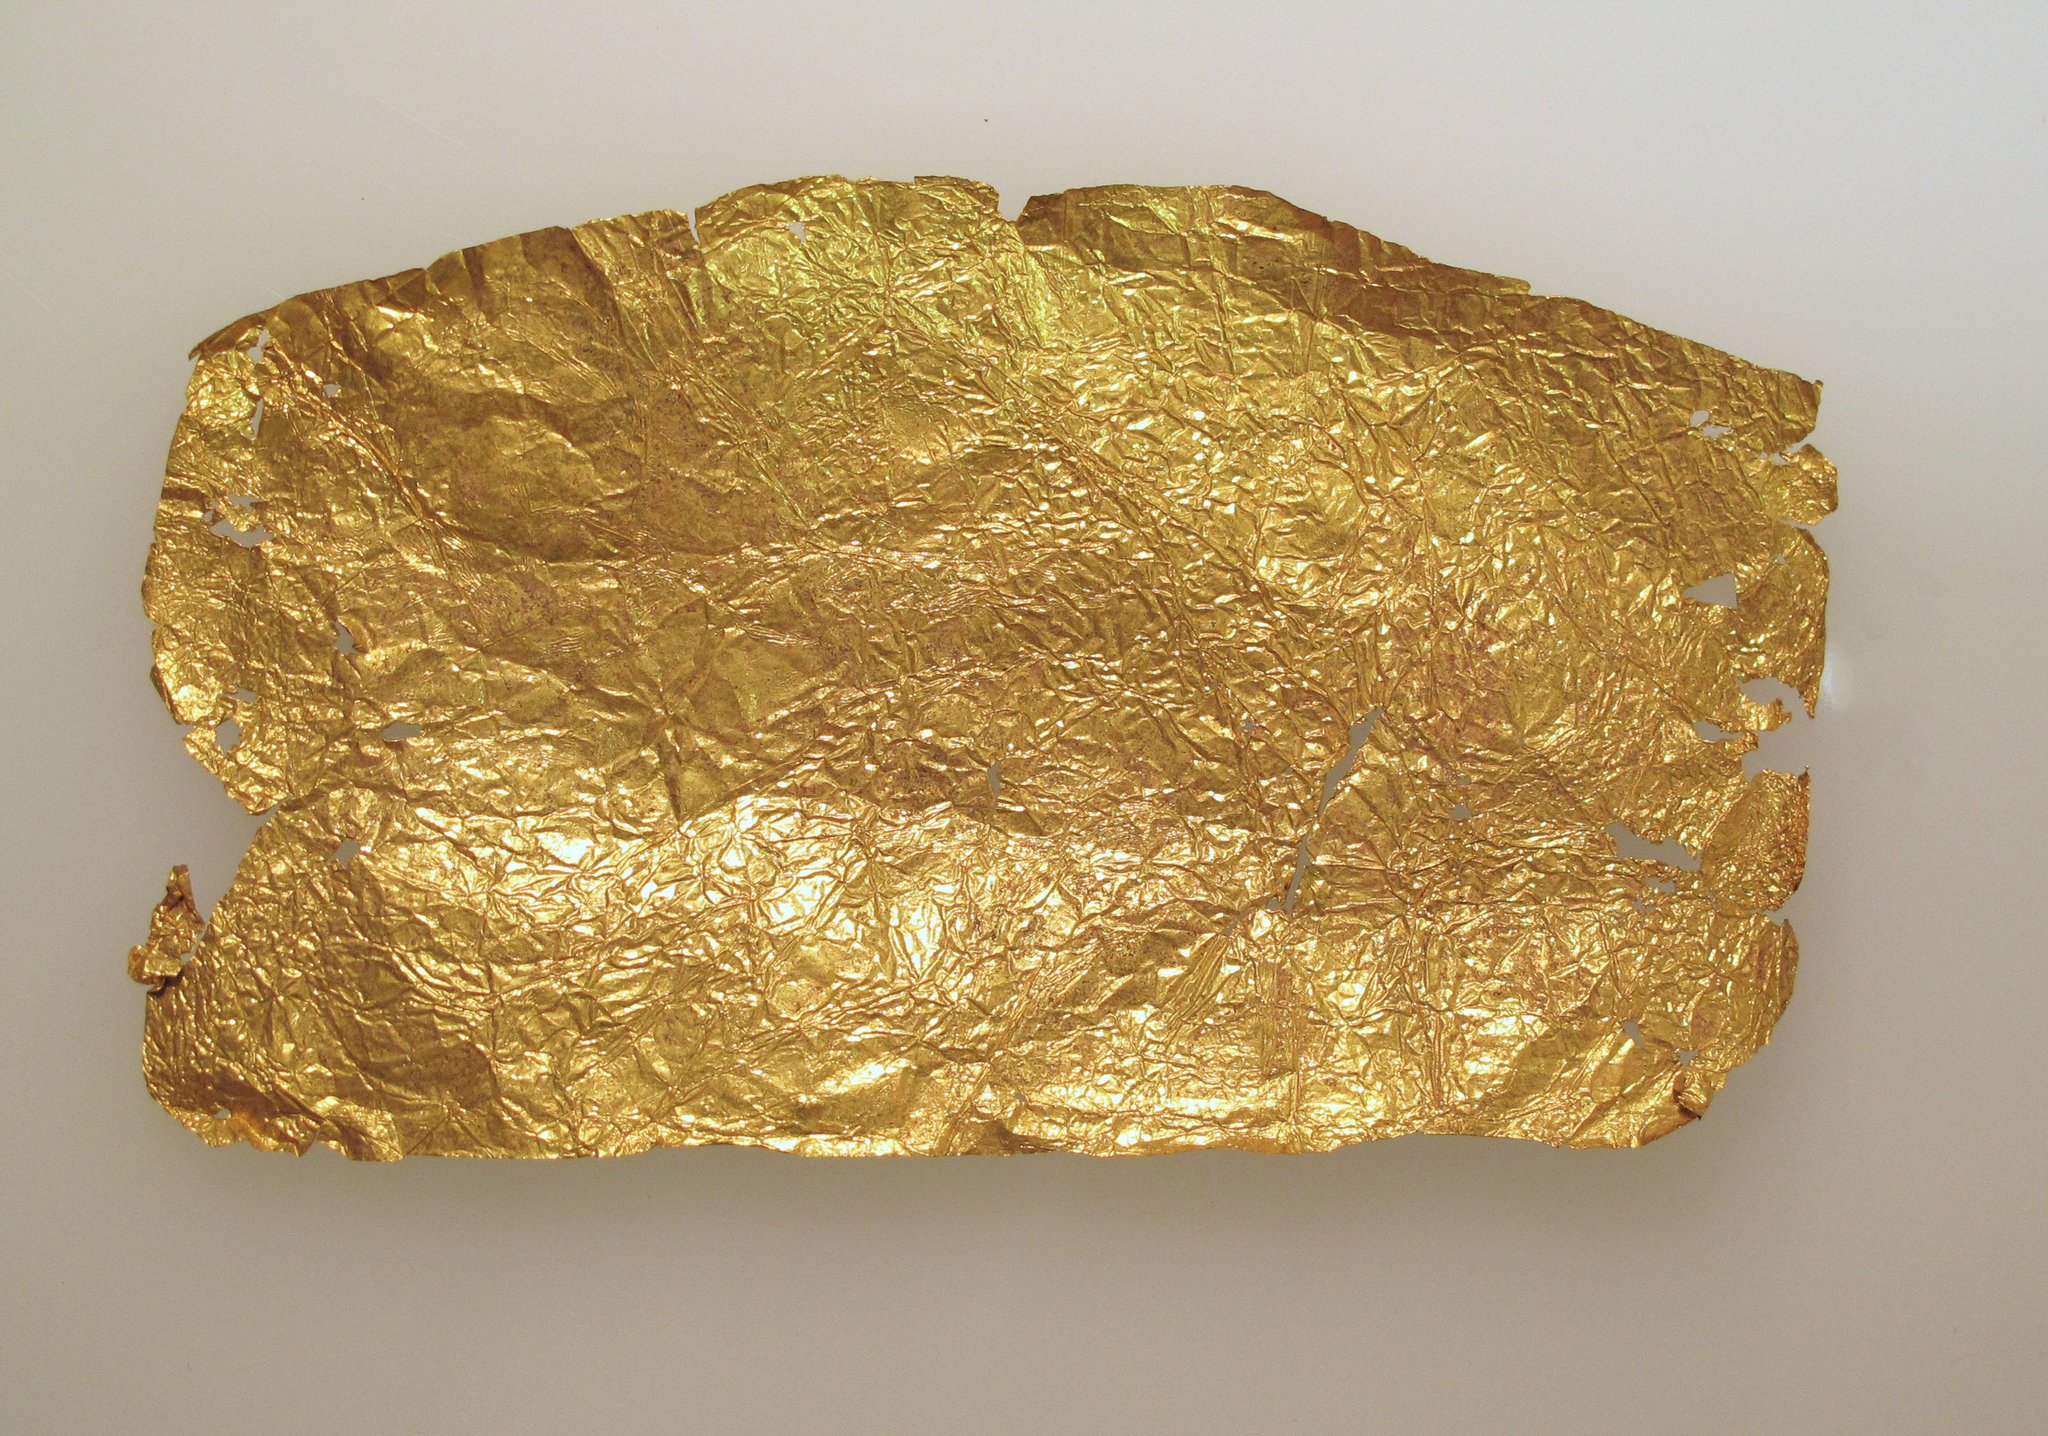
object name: frontlet of gold leaf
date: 7000 BCE-330 CE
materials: gold